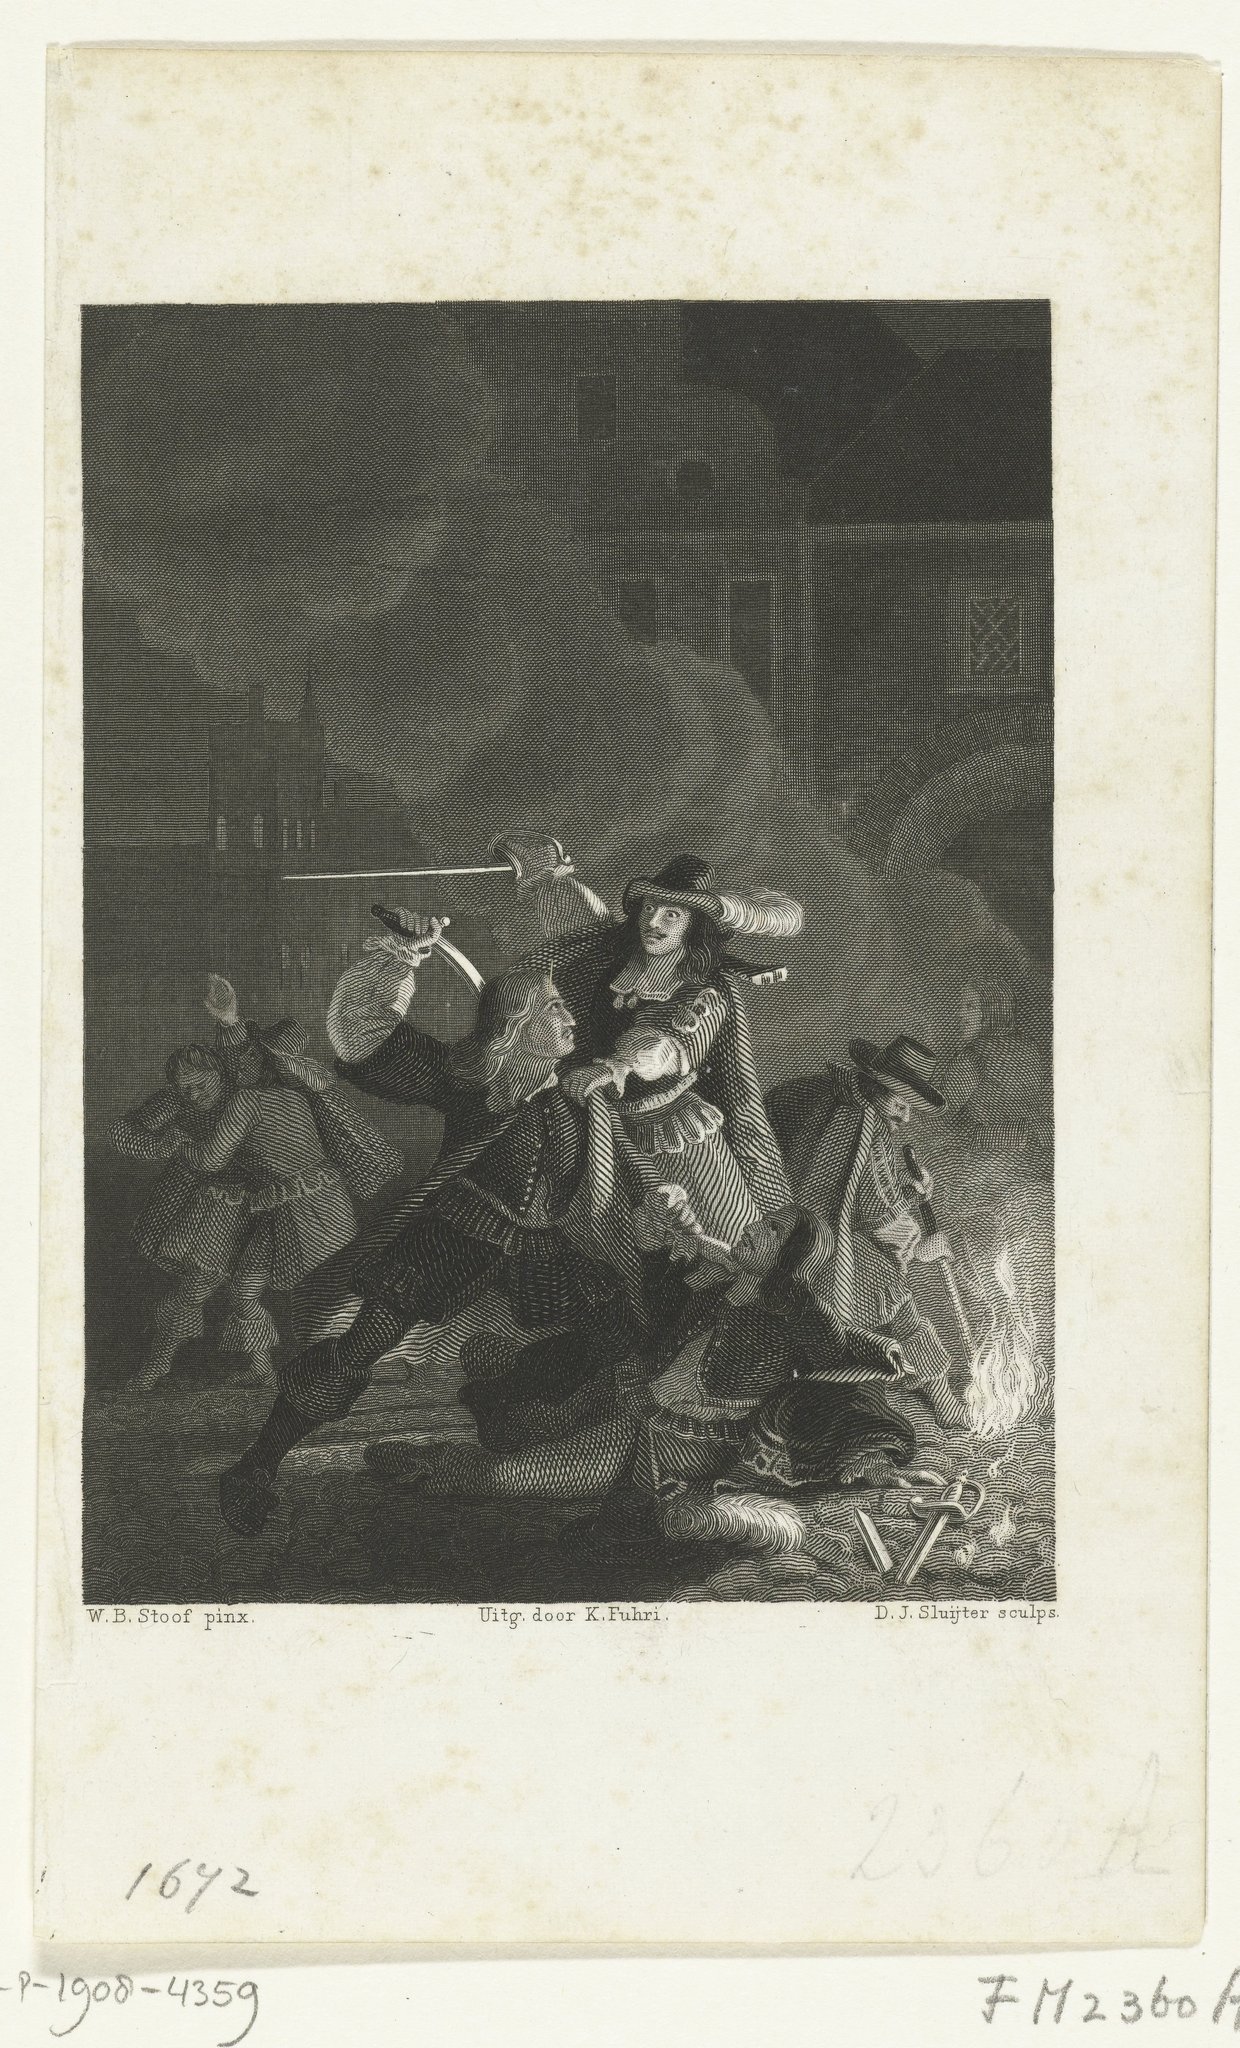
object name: history print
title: Johan de Witt 's nachts op straat aangevallen, 1672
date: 1842-1844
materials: paper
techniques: engraving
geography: netherlands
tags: the hague, politician, johan de witt, fighting, rampjaar (disaster year)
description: Raadpensionaris Johan de Witt wordt 's nachts op straat aangevallen door een groep gewapende mannen en raakt zwaar gewond, juni 1672.